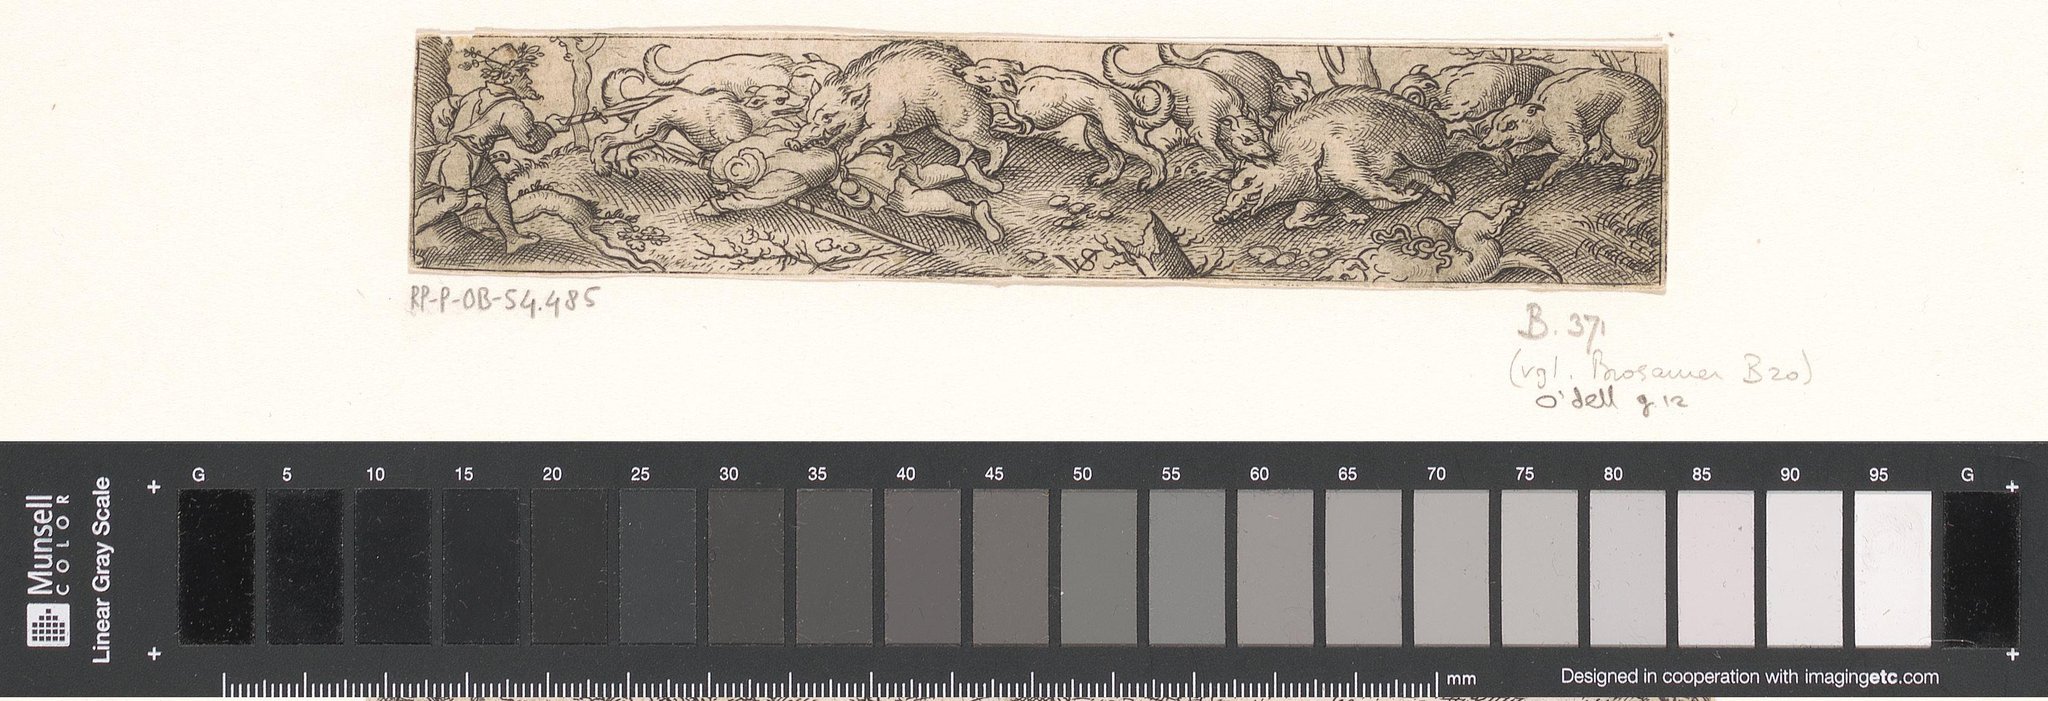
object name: print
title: Jager aangevallen door wilde zwijnen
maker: virgilius solis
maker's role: draughtsman, print maker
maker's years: 1514-1562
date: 1524-1562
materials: paper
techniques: engraving, etching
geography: nuremberg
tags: hunted animal attacking man, boar-hunting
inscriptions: number: ‘3[...]’, collector's mark: Lugt 2228